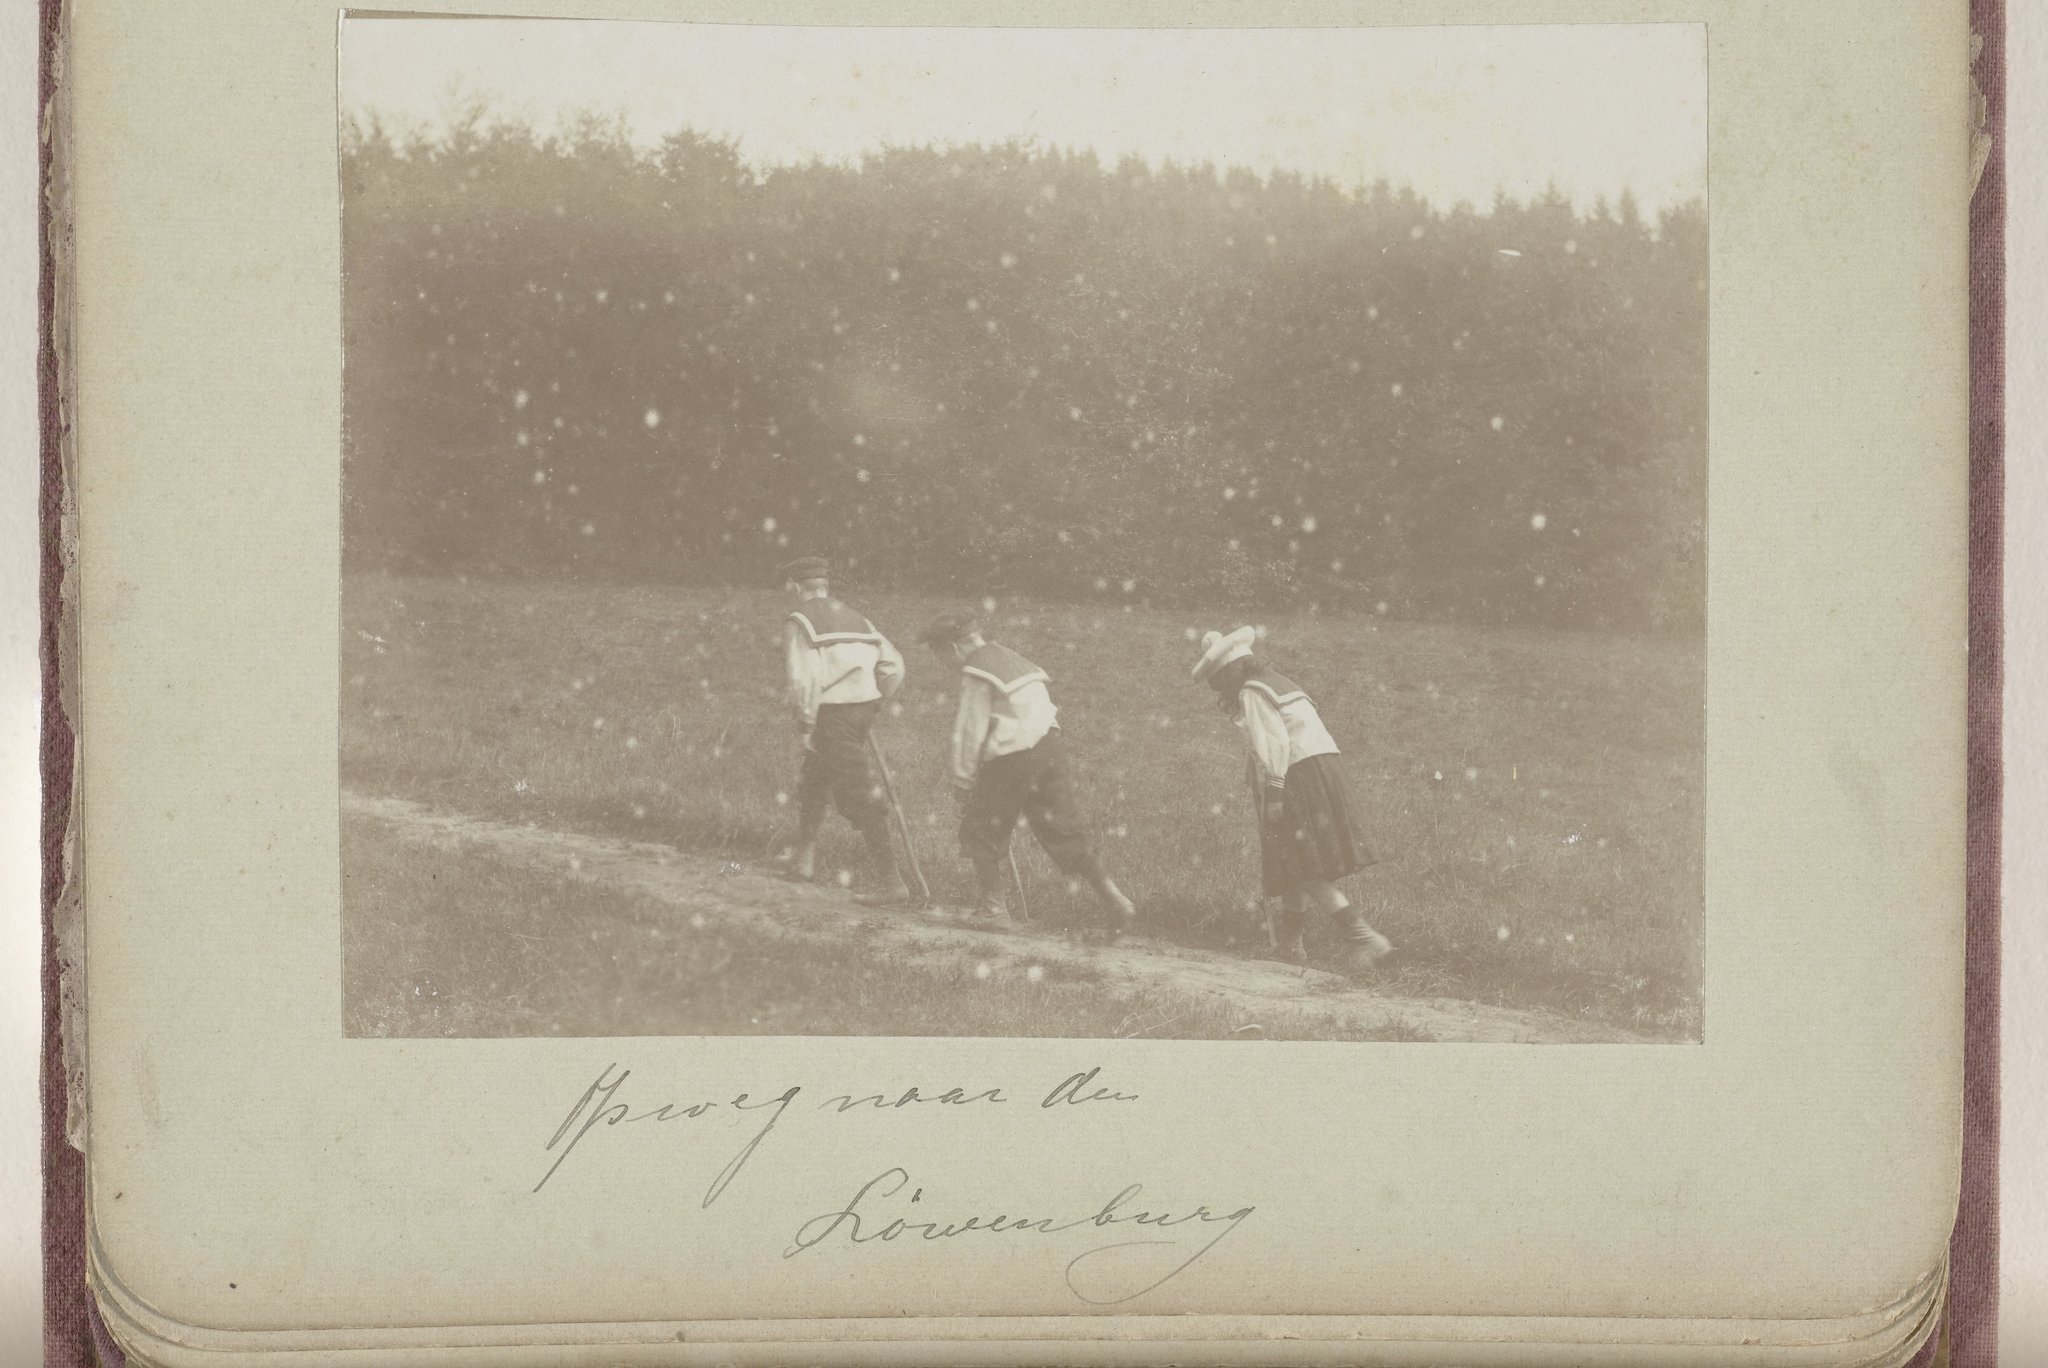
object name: album leaf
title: Op weg naar de Löwenburg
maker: david vermeulen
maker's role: fotograaf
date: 1895-1905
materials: paper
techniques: collodion silver print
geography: north rhine-westphalia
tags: amsterdam, strolling, ensemble of pieces of clothing: sailor suit, child between toddler and youth (of undetermined sex)